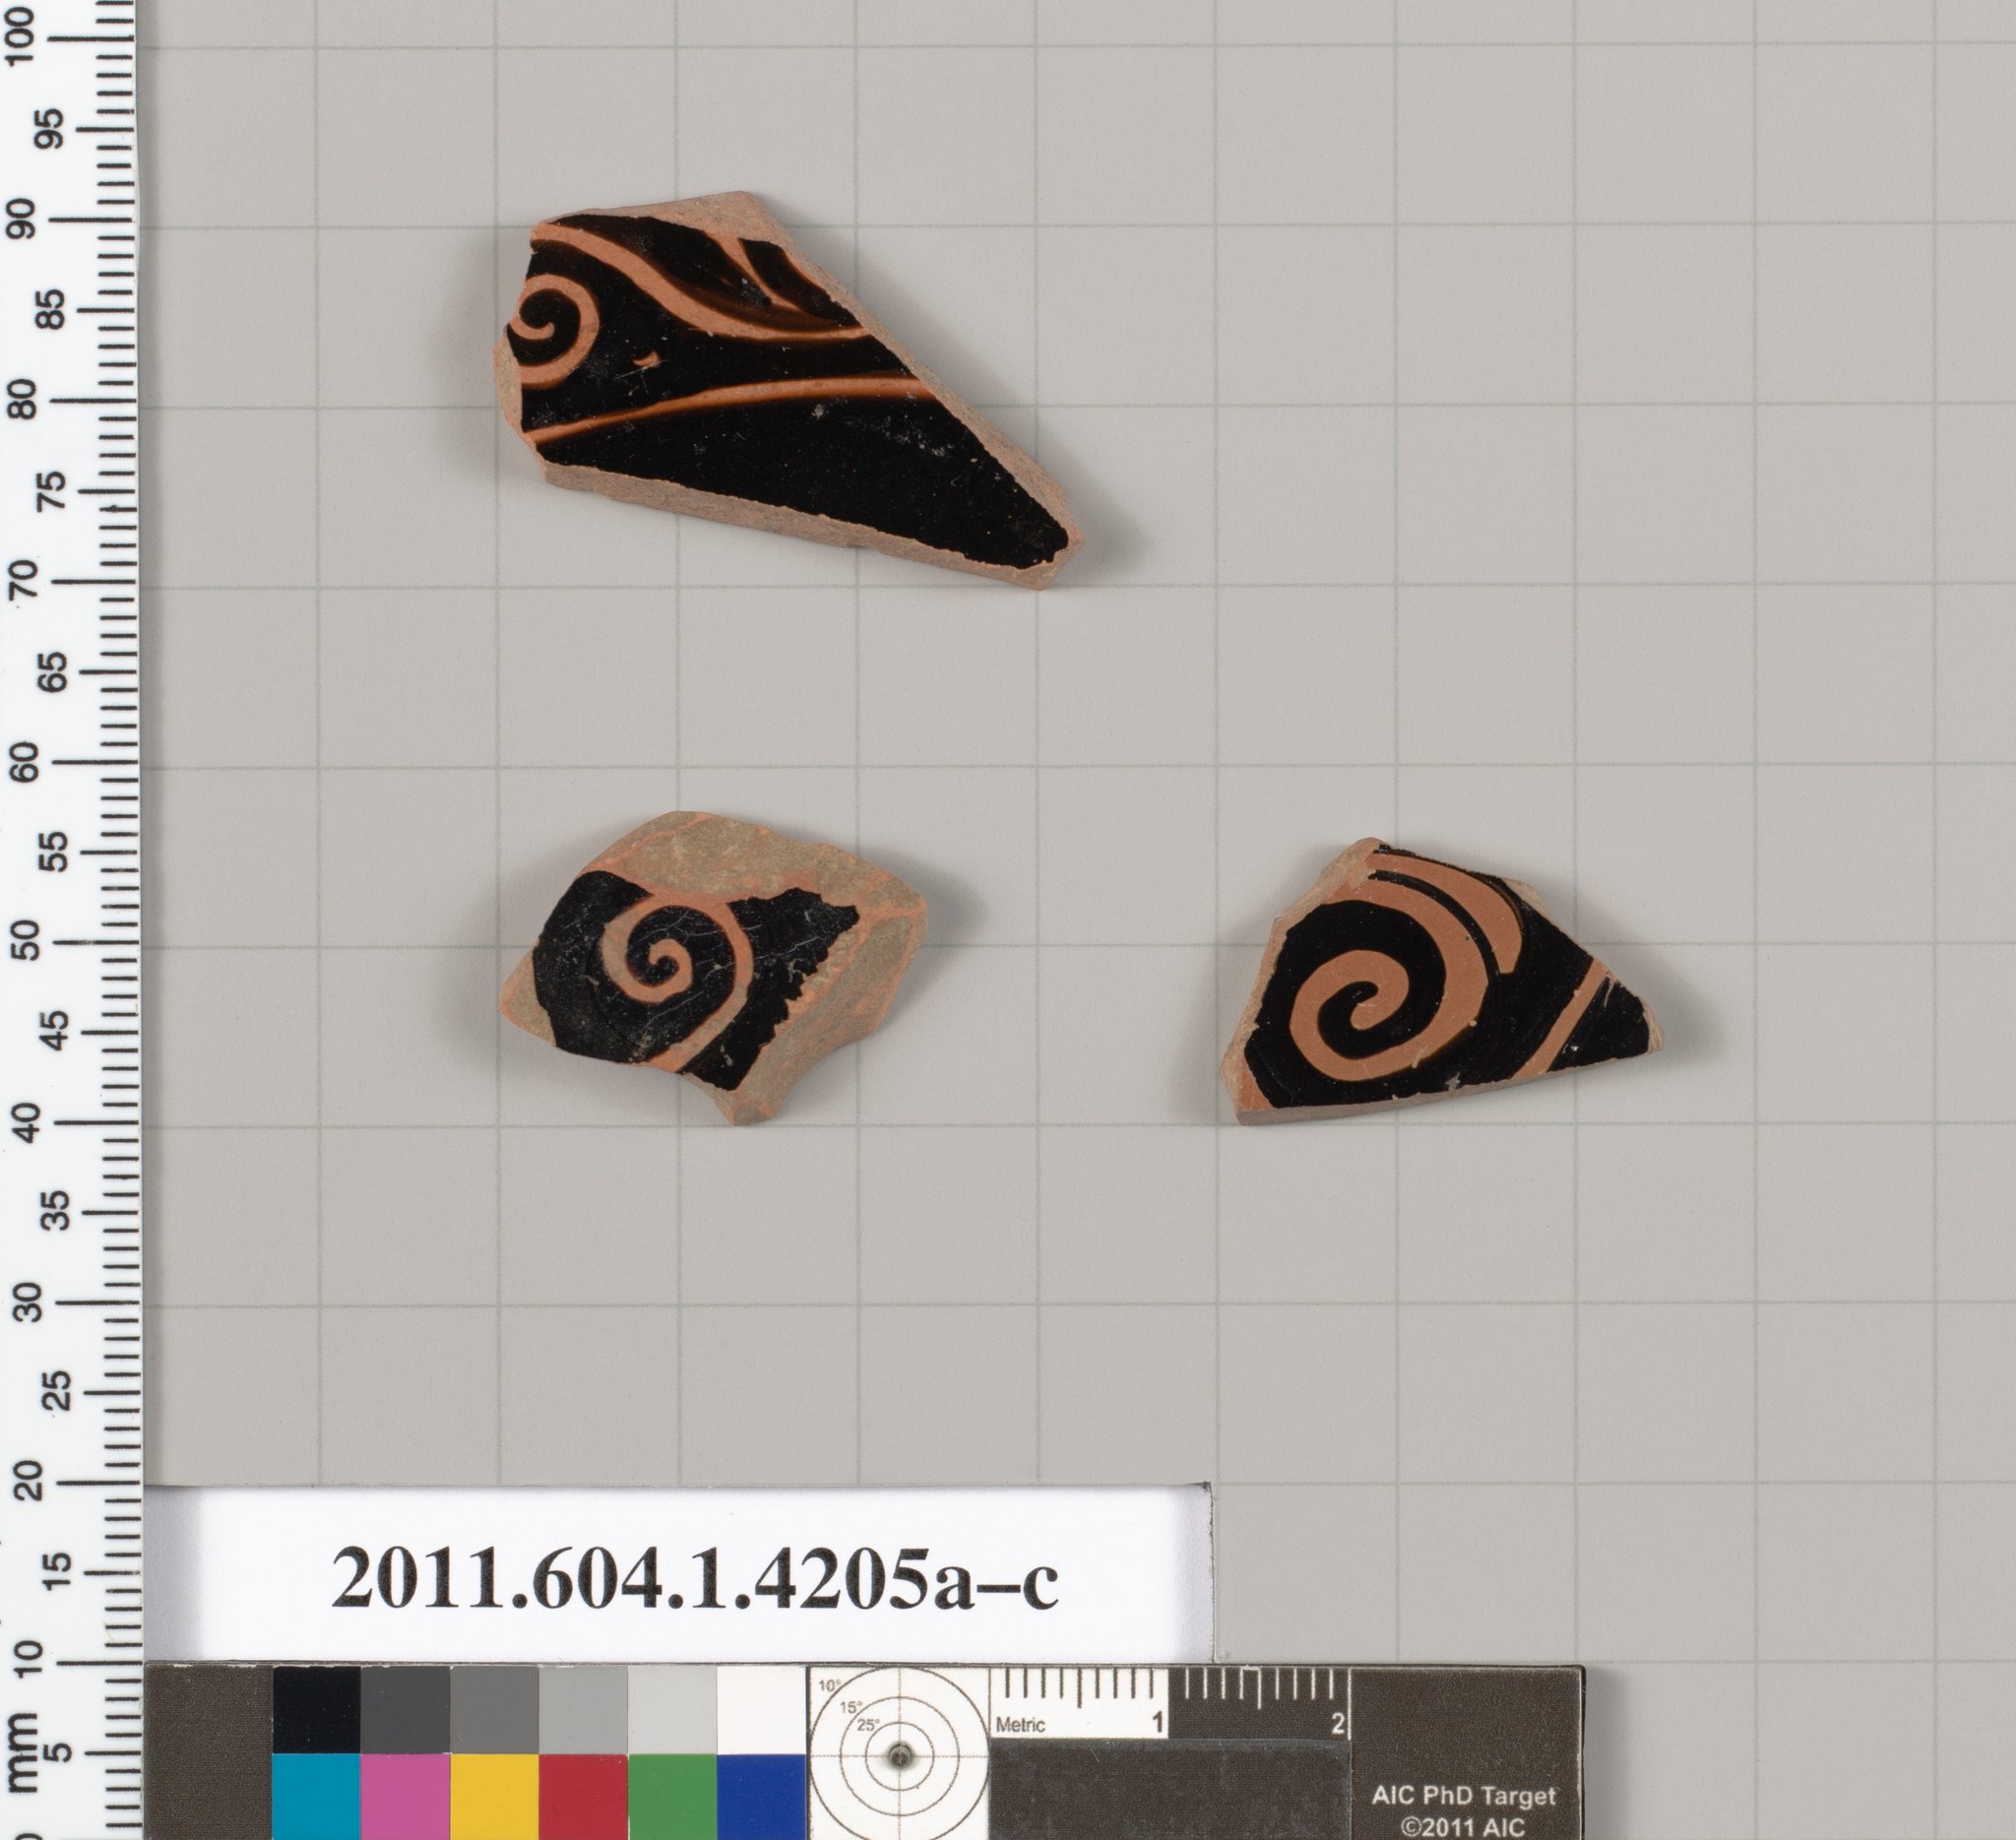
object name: kylix fragment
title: Terracotta fragments of kylikes (drinking cups)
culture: greek, attic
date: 500-451 BCE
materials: terracotta